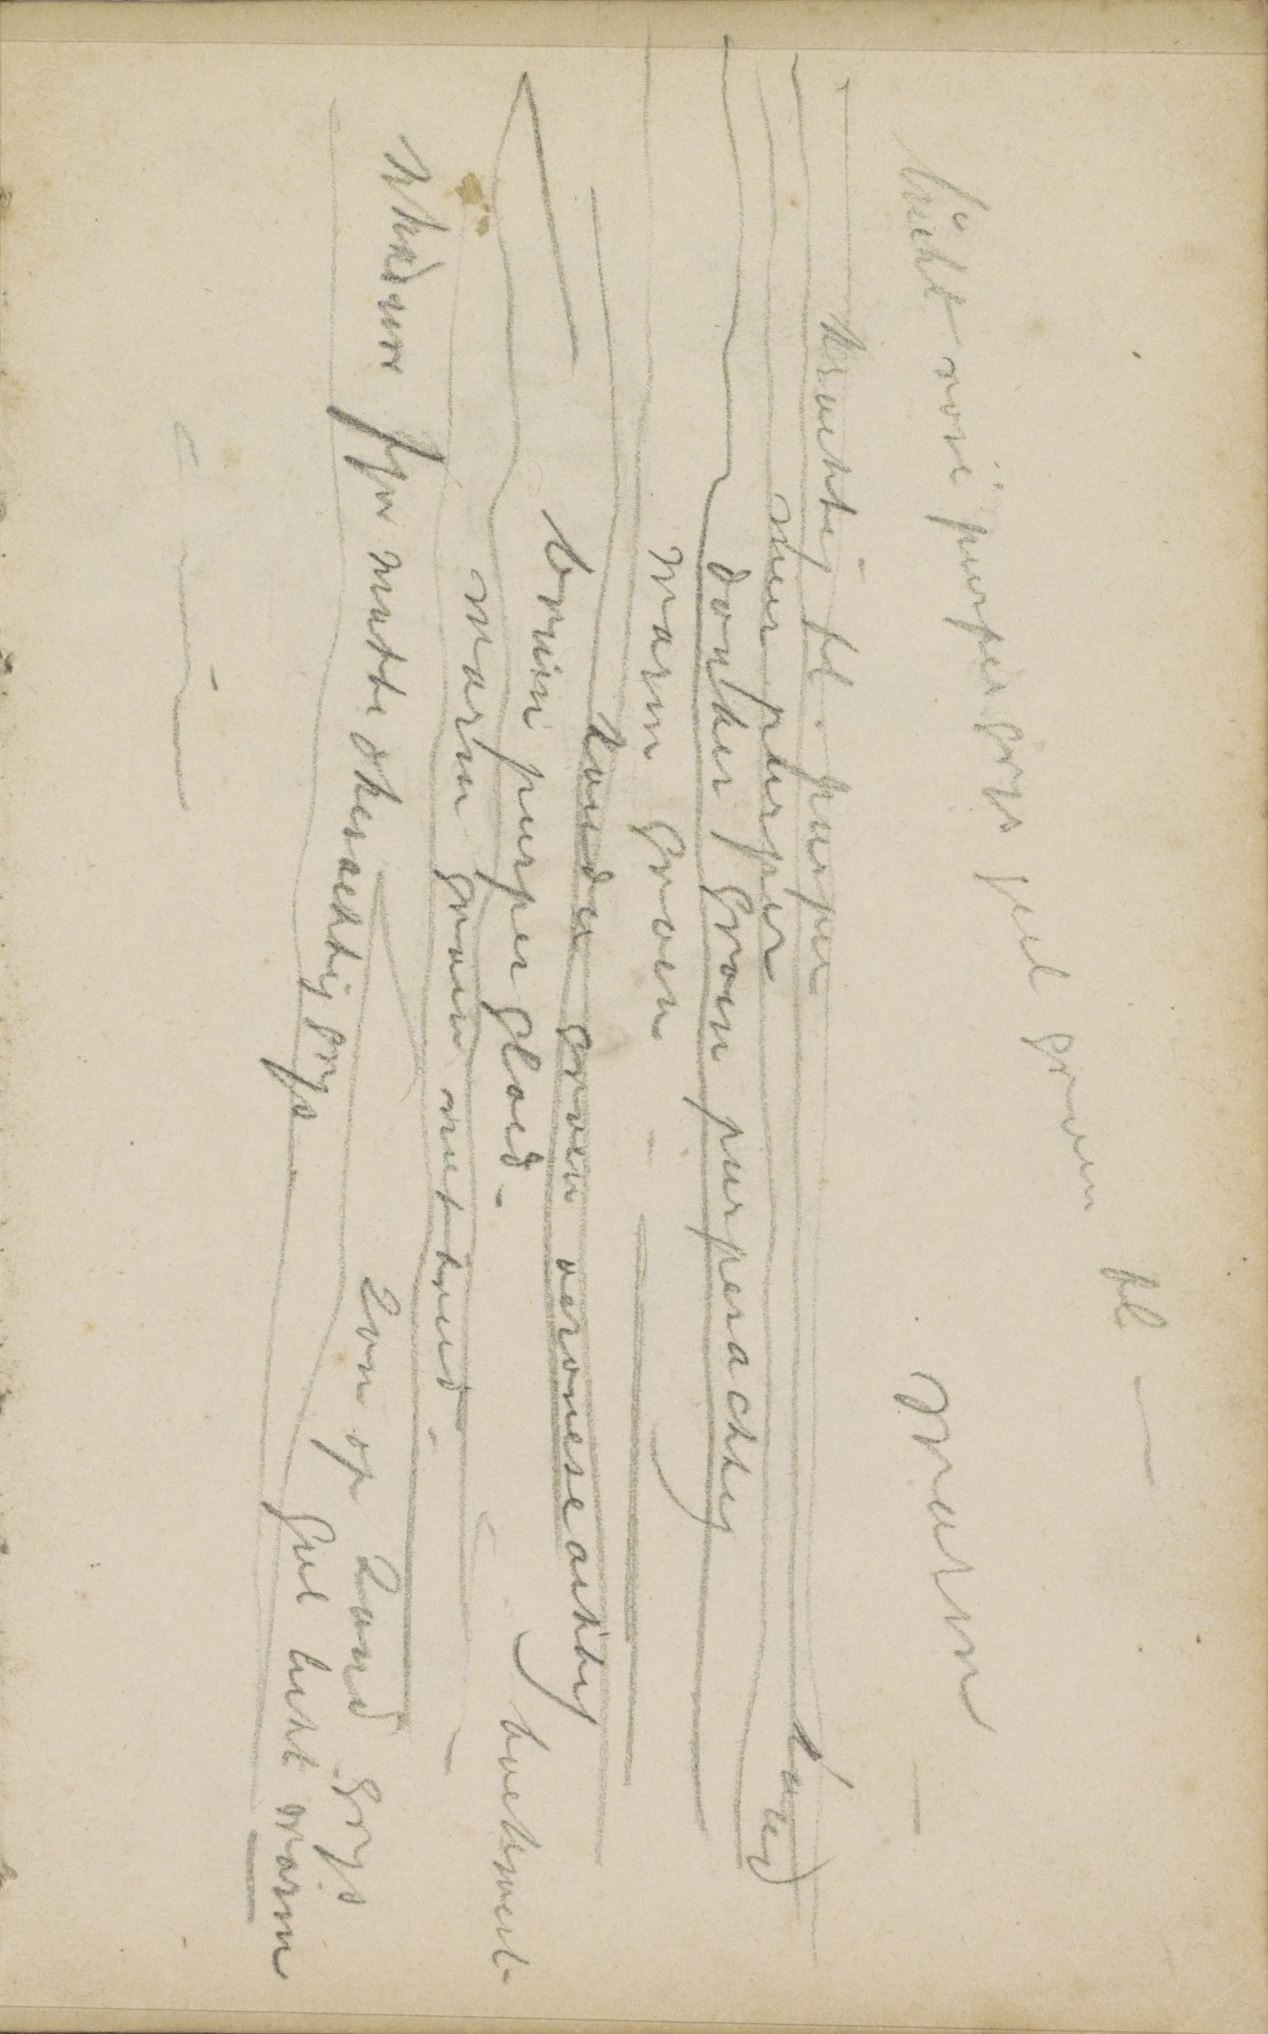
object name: sketchbook leaf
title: Landschap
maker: johannes tavenraat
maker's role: draughtsman, painter, print maker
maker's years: 1809-1881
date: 1839-1872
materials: paper, pencil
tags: landscapes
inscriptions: kleurnotitie, handgeschreven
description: Blad 68 recto uit een schetsboek met 73 bladen.